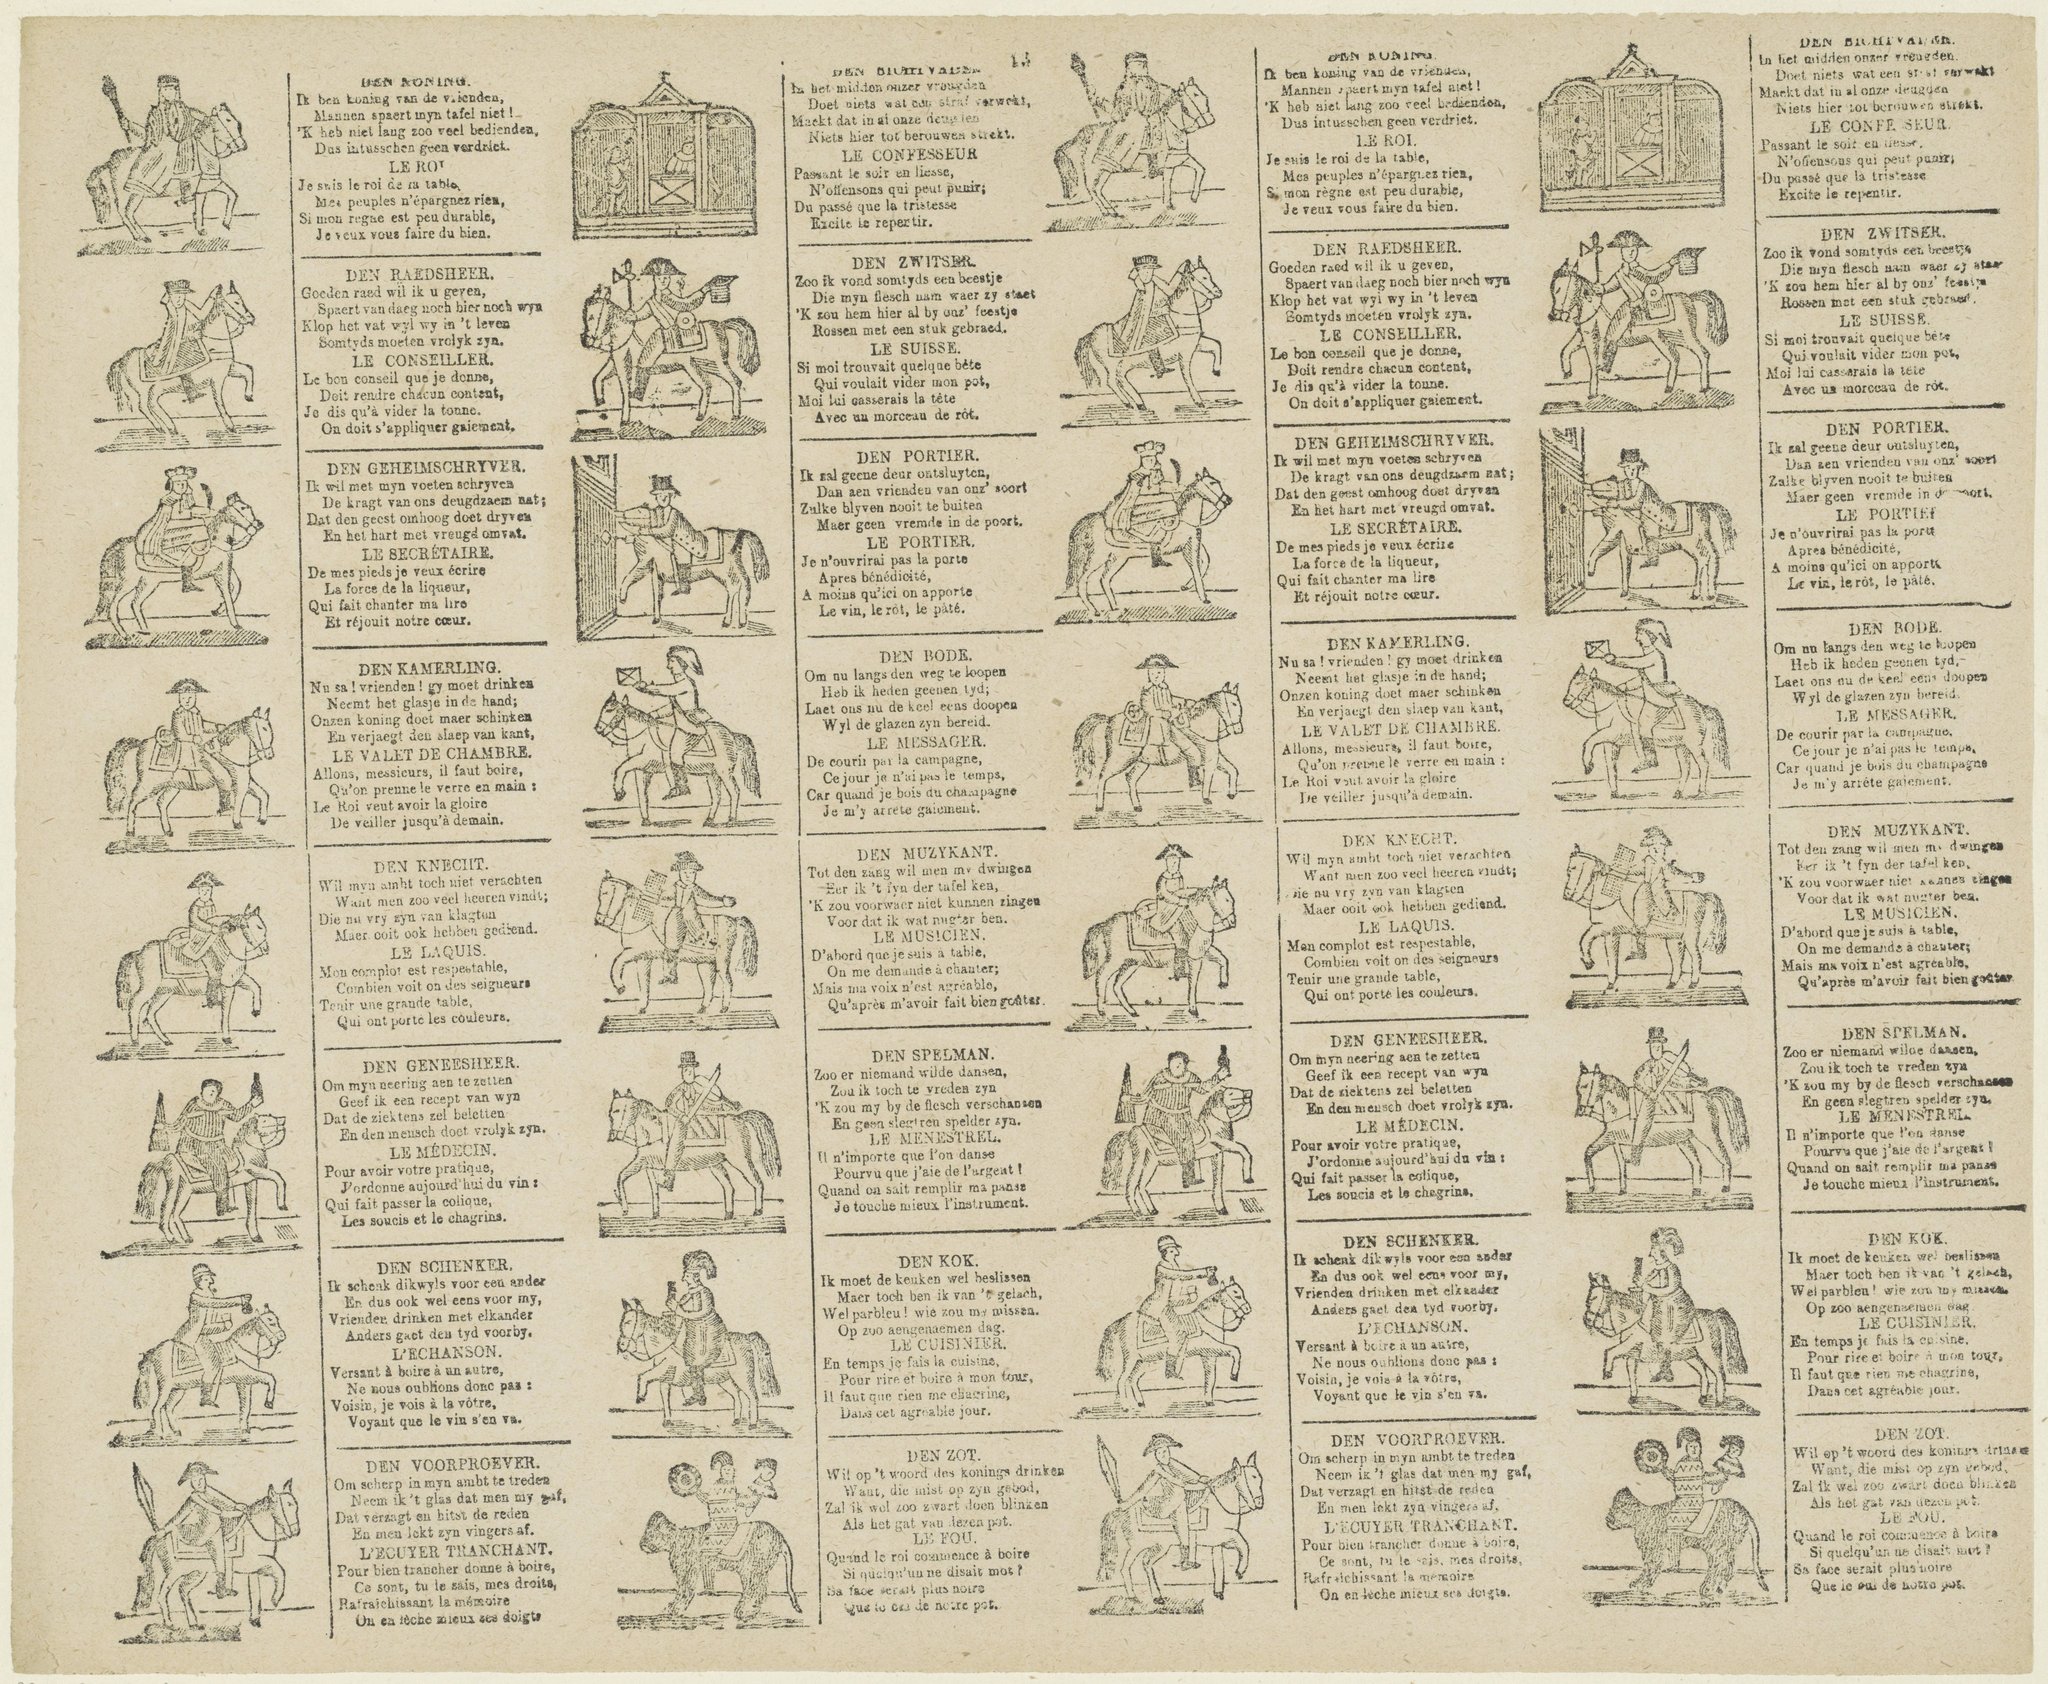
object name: popular print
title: Driekoningenbriefjes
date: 1827-1894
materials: paper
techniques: letterpress printing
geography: schaarbeek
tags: twelfth night, usually falling on the eve of january 6, royal household; courtiers, retinue, train, epiphany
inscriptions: collector's mark: Lugt 2760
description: Blad met 32 voorstellingen (driekoningenbriefjes) van verschillende functies binnen het hof, waaronder een raadsman, een proever en een portier. Rechts naast elke afbeelding een vierregelig vers in het Nederlands en in het Frans. Genummerd midden boven: 43.